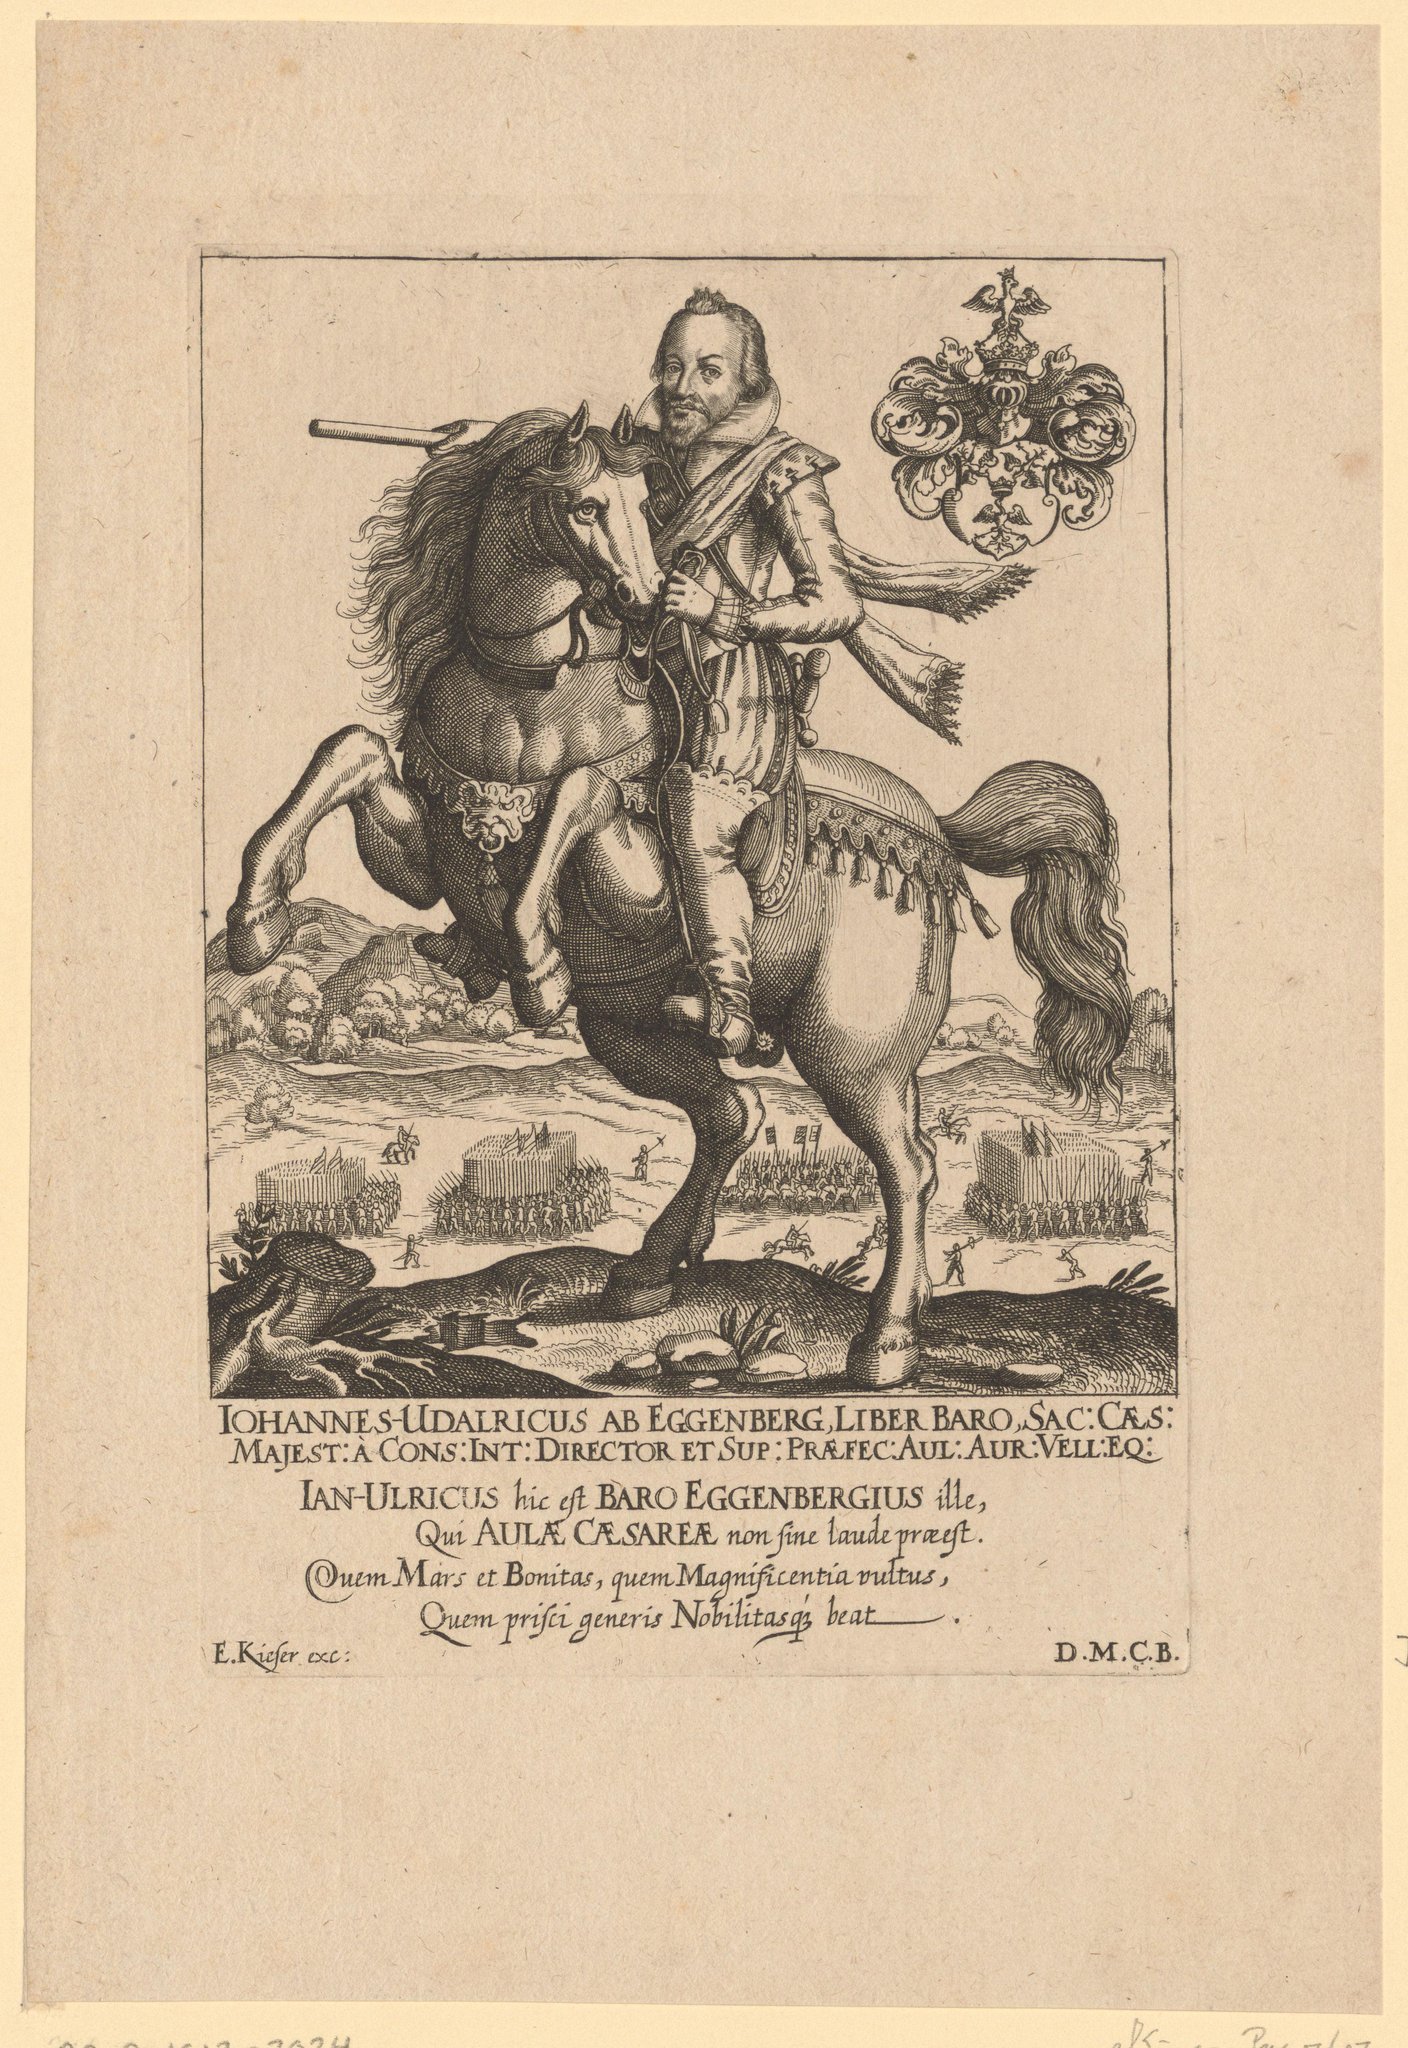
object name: print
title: Portret van Johann Ulrich von Eggenberg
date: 1600-1631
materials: paper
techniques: engraving, etching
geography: frankfurt am main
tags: equestrian state-portrait, historical persons, officer, armorial bearing, heraldry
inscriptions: collector's mark: Lugt 2228